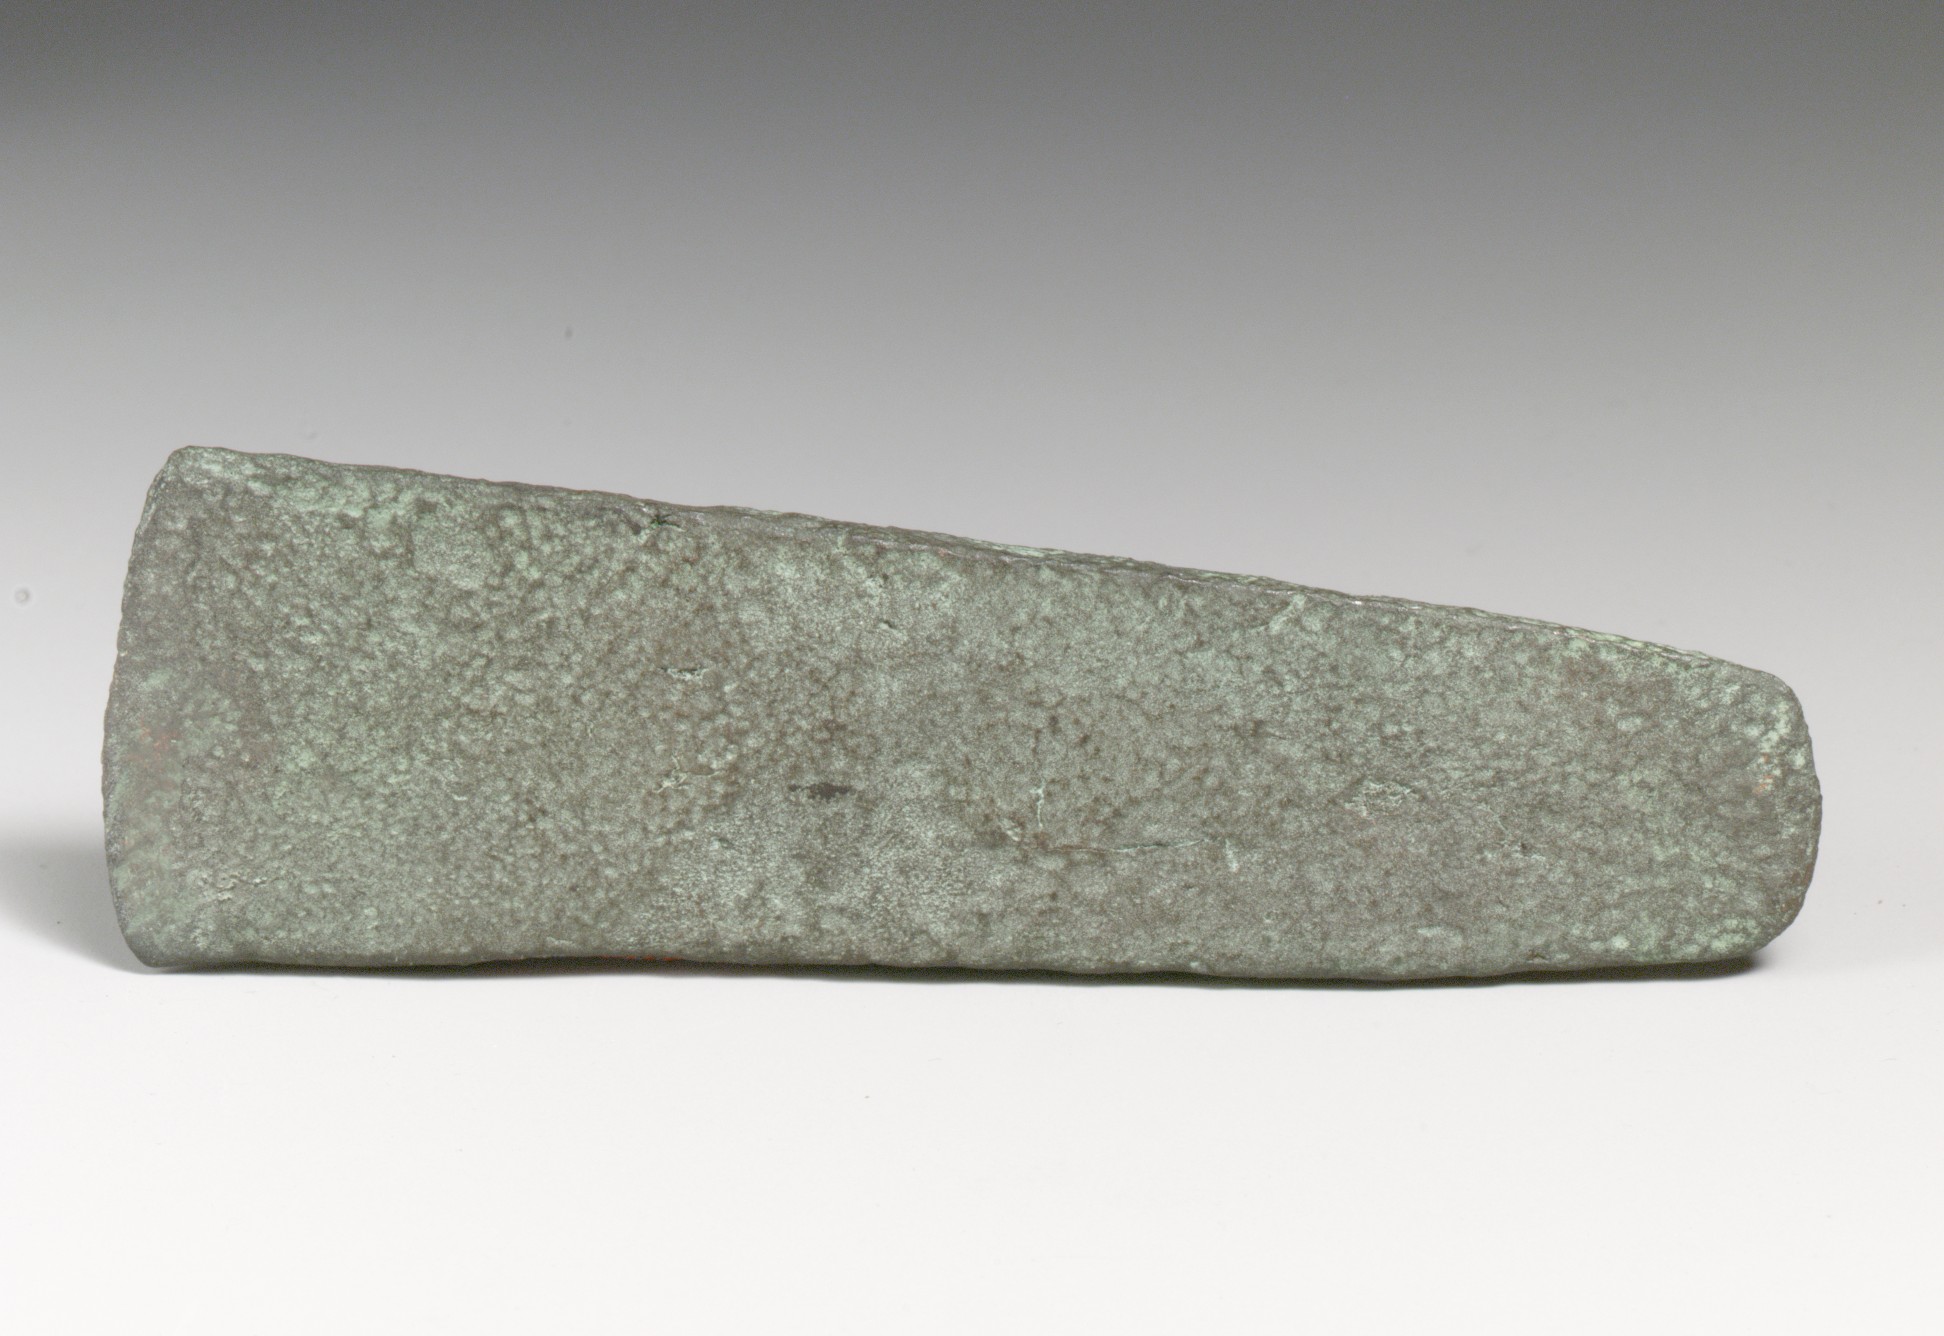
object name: axehead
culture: cypriot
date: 3200-2000 BCE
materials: bronze